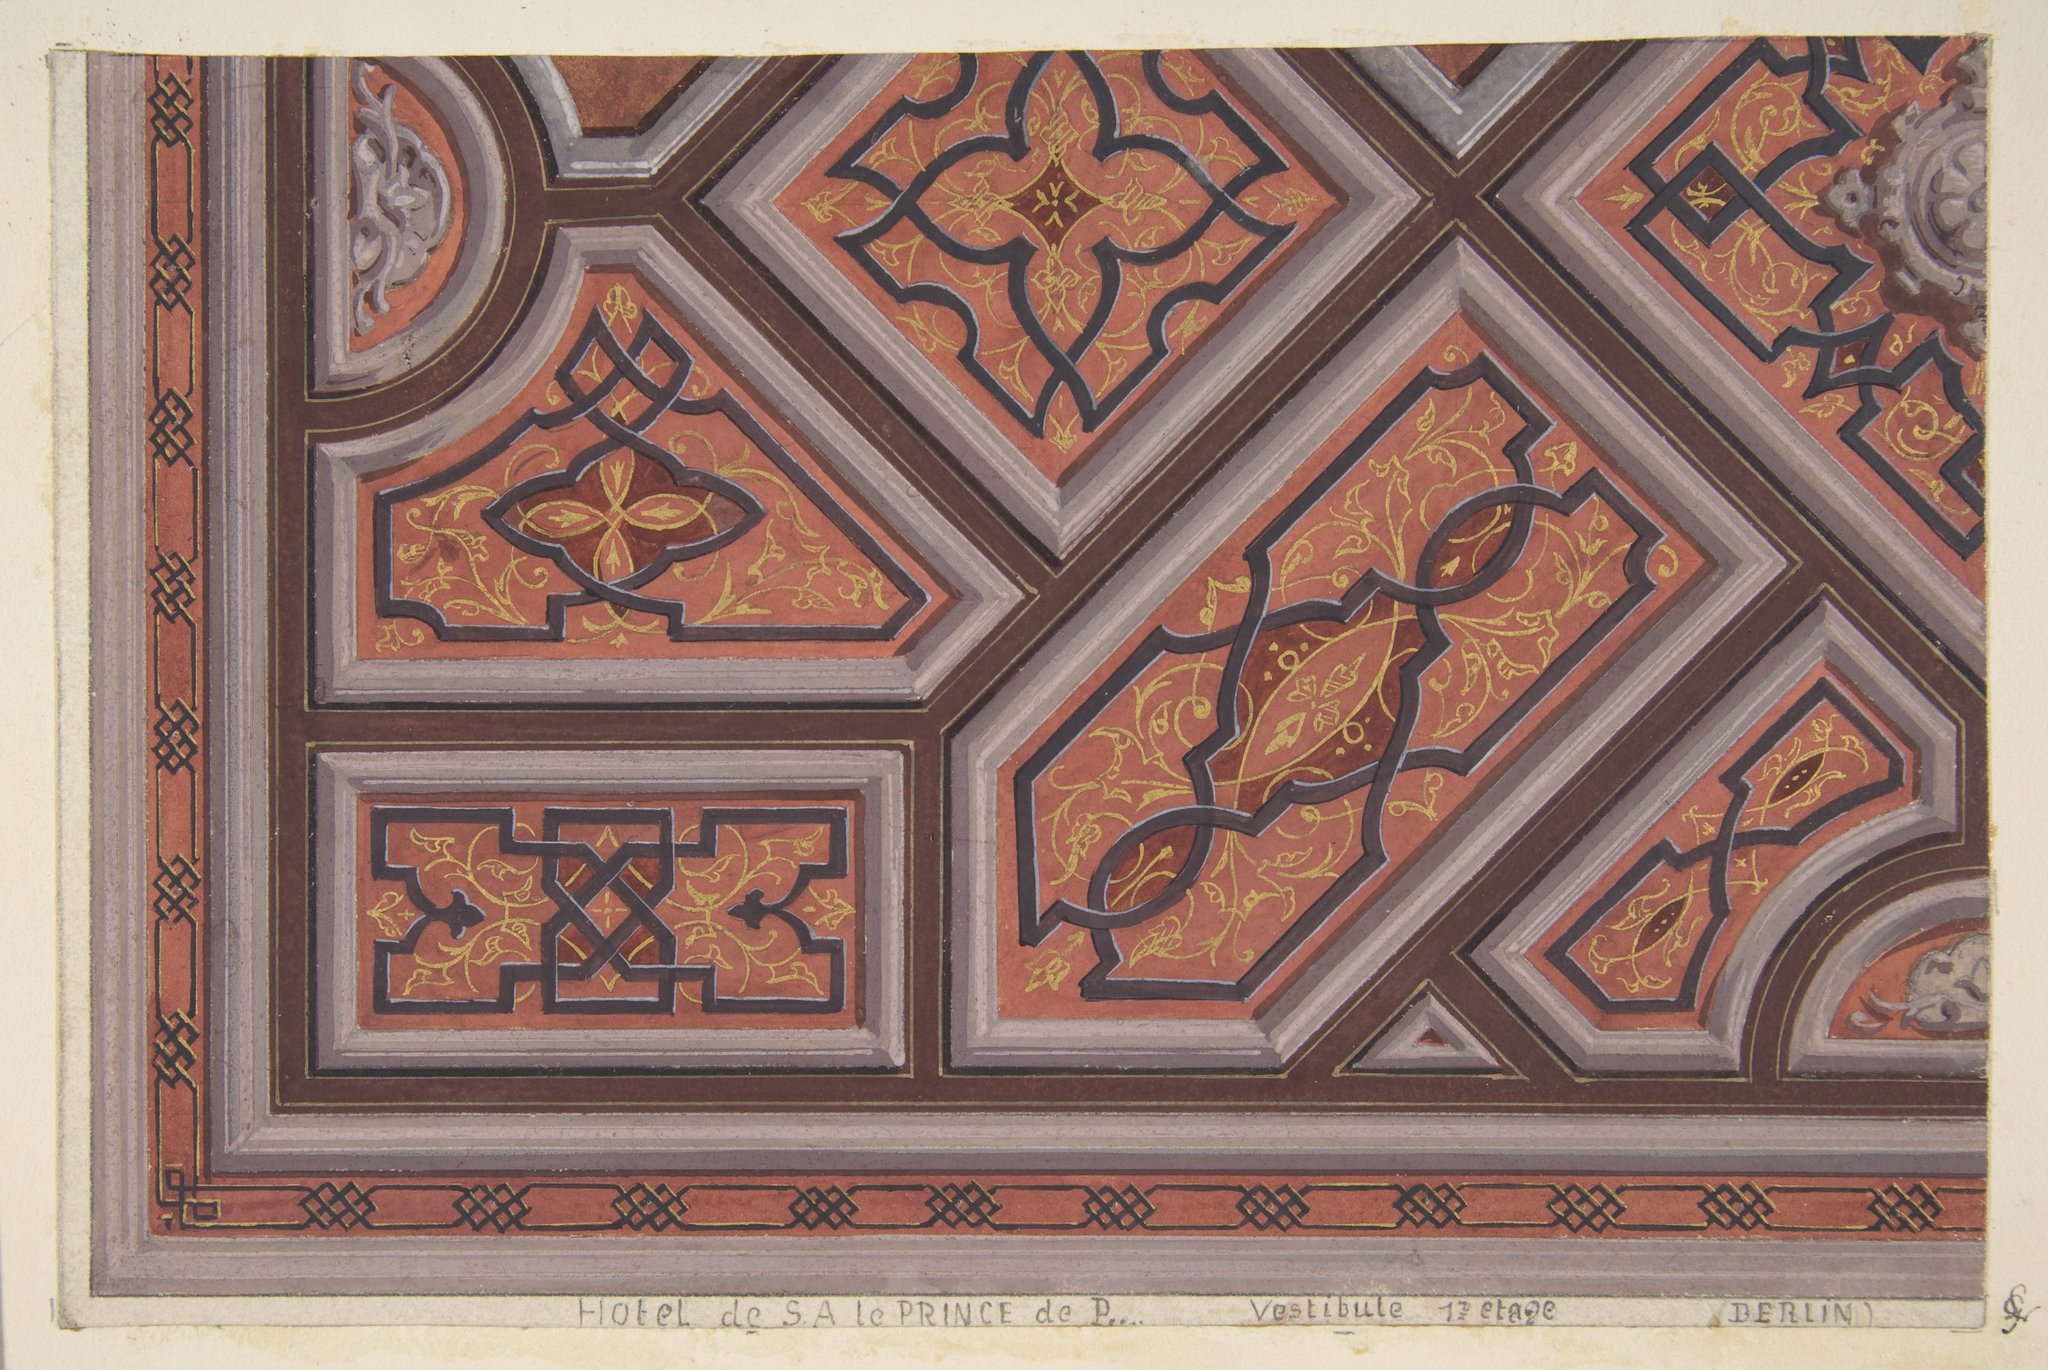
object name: drawing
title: Design for the Decoration of the Ceiling in the Vestibule (Ier étage), Hôtel de S. A. le Prince de P... [Pless?}, Berlin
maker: jules-edmond-charles lachaise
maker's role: artist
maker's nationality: french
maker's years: 1897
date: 1851-1900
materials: gold paint, gouache, watercolor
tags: architecture